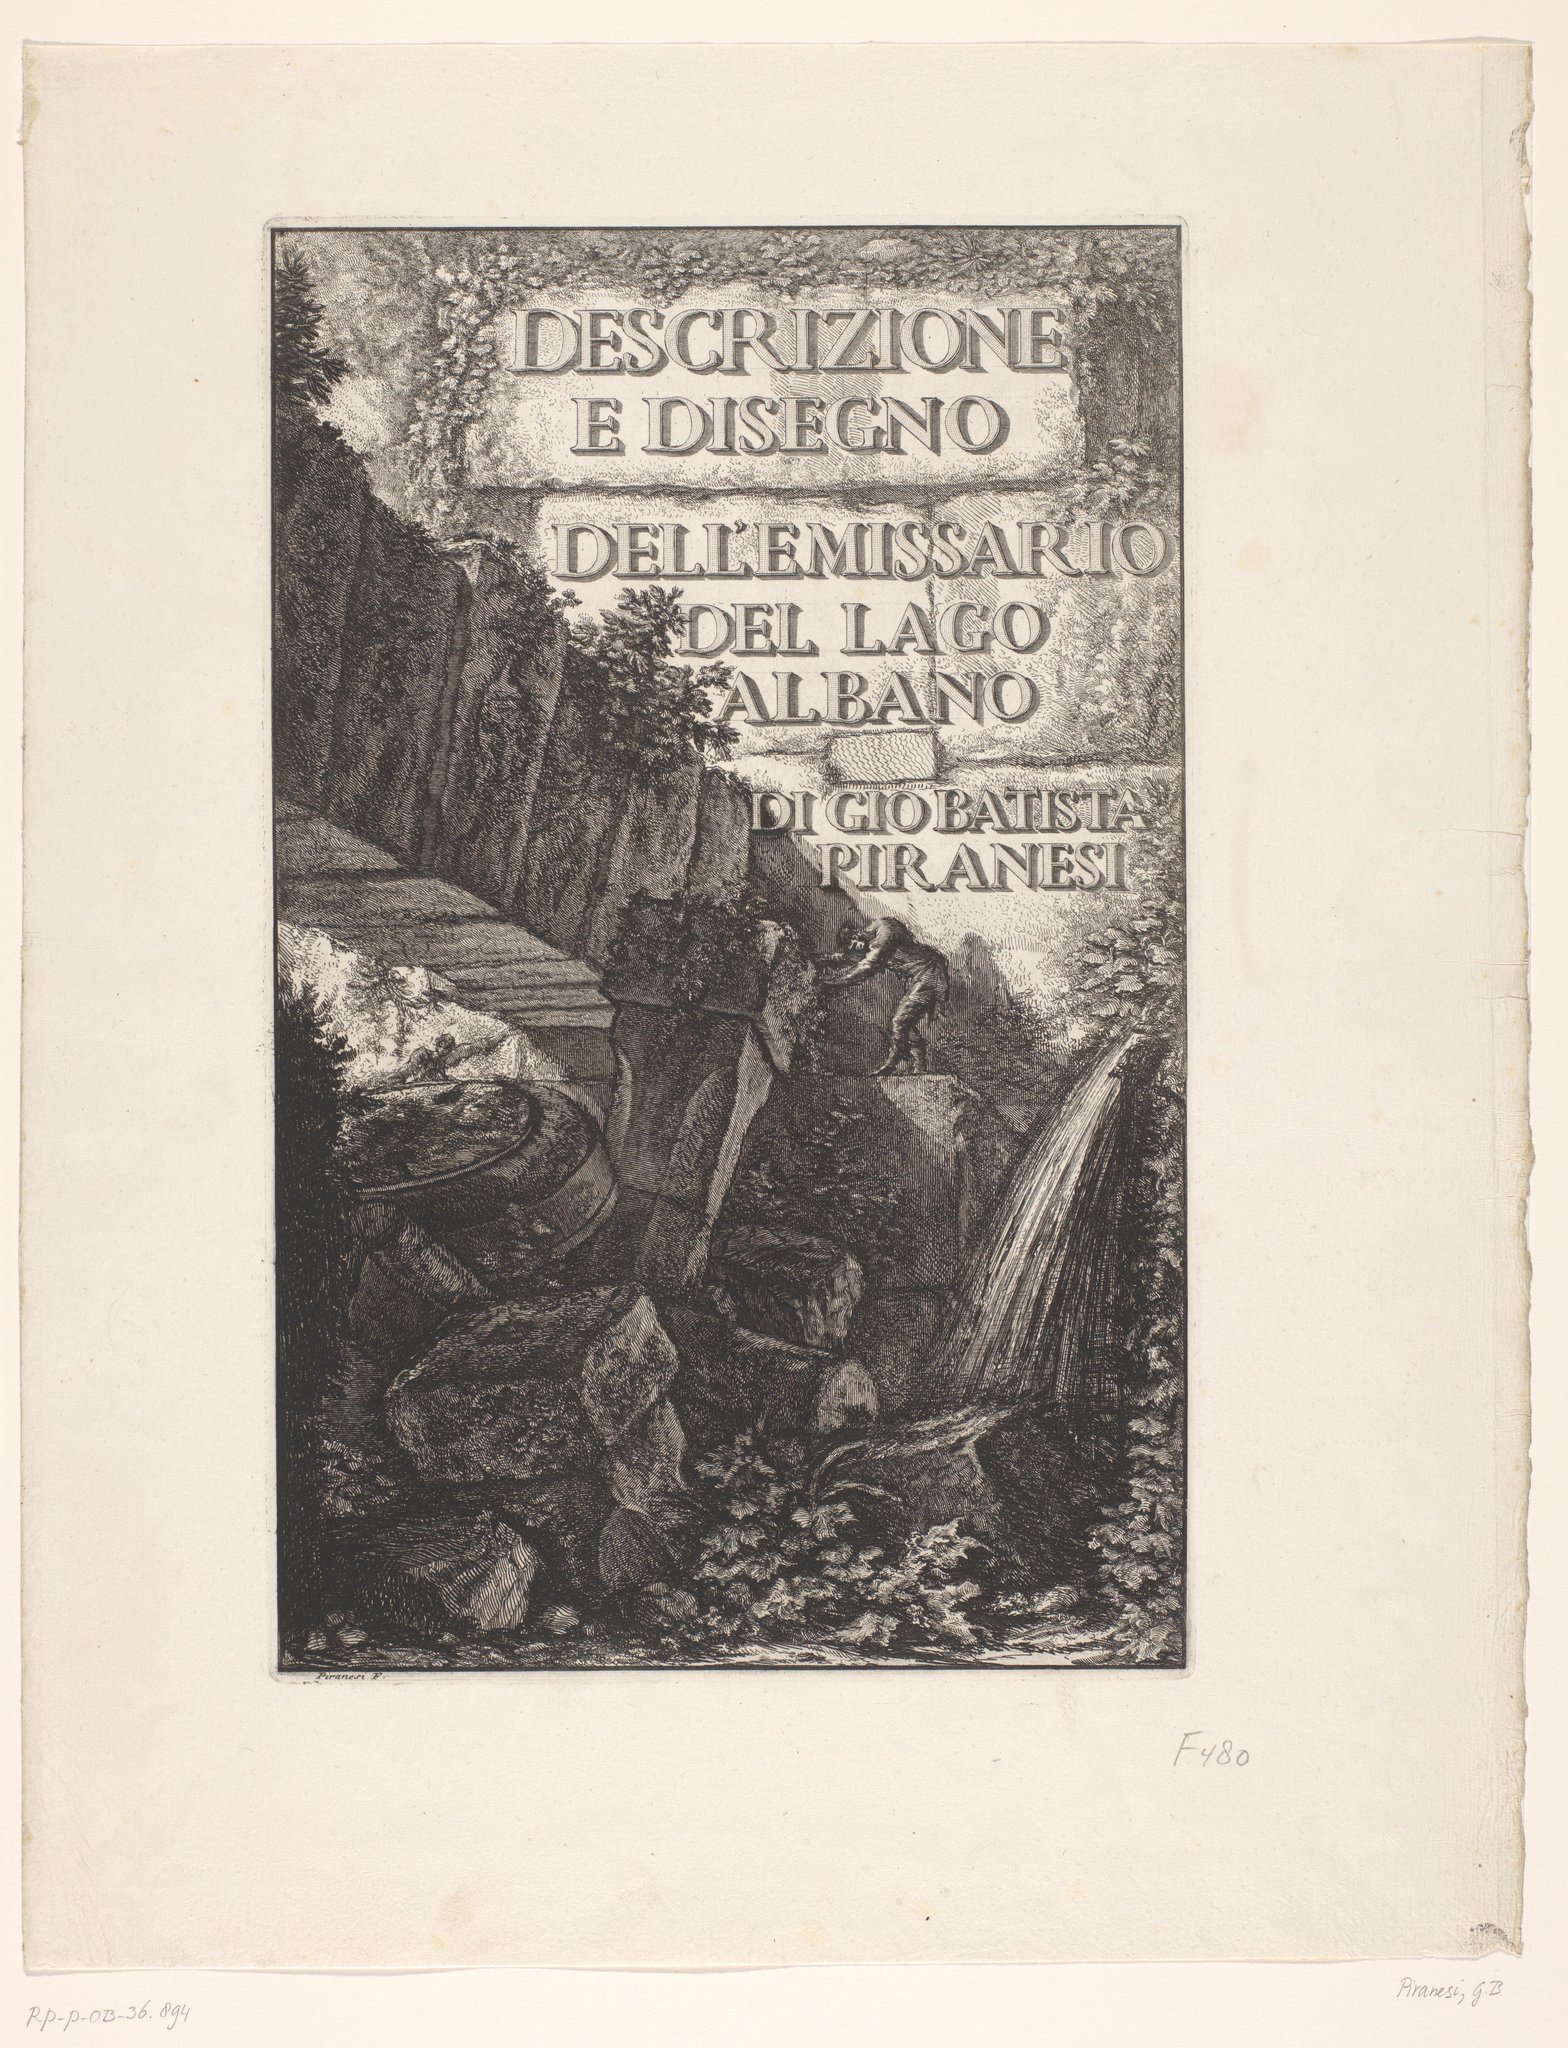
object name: titelprent, frontispice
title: Descrizione e disegno dell'emissario del Lago Albano di Gio Batista Piranesi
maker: giovanni battista piranesi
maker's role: designer, draughtsman, print maker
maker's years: 1720-1778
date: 1762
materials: paper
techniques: etching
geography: rome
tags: ruin of a building ~ architecture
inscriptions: collector's mark: Lugt 2228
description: Titelprent van de serie 'Descrizione e Disegno dell'Emissario del Lago Albano'. De serie bestaat uit een titelprent, een vignet, een geornamenteerde letter en negen prenten.